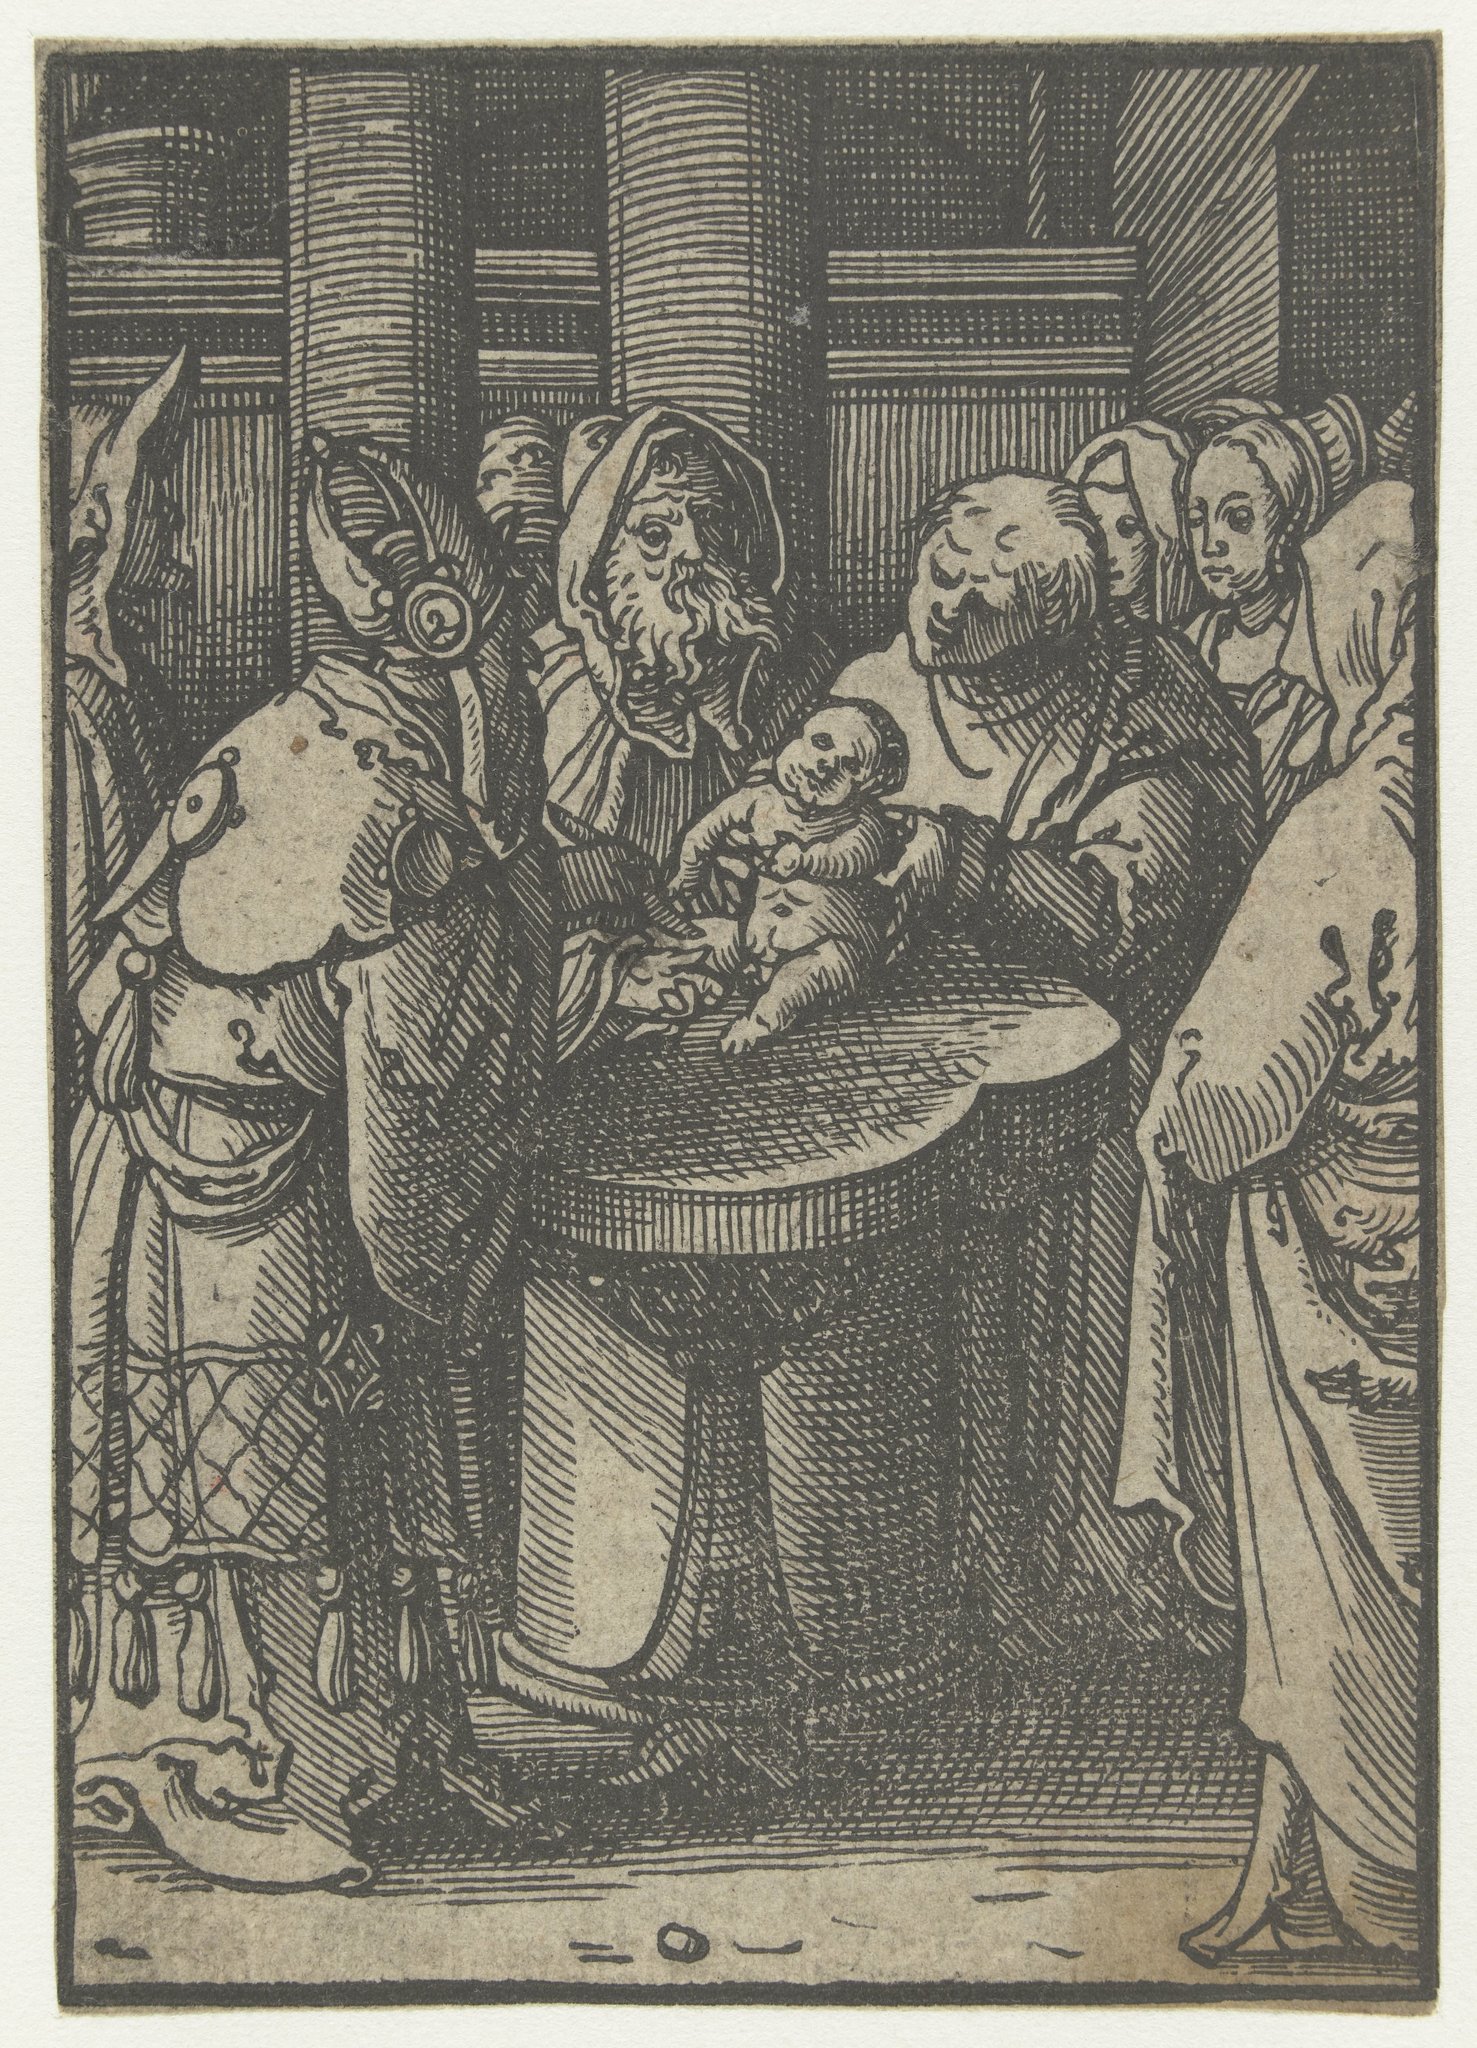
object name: print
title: De besnijdenis van Christus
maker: lucas van leyden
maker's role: draughtsman, painter, print maker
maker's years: 1494-1533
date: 1518-1522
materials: paper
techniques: woodcut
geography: low countries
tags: book in which illustrations are essential, circumcision of the christ-child by the priest in the temple (luke 2:21)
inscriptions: collector's mark: Lugt 240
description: Houtsnede gebruikt als illustratie in "Hier begint een scoone stomme passye ... tot LXXX fighuren toe", uitgegeven door Doen Pietersz. te Amsterdam, waarschijnlijk ná 1526.